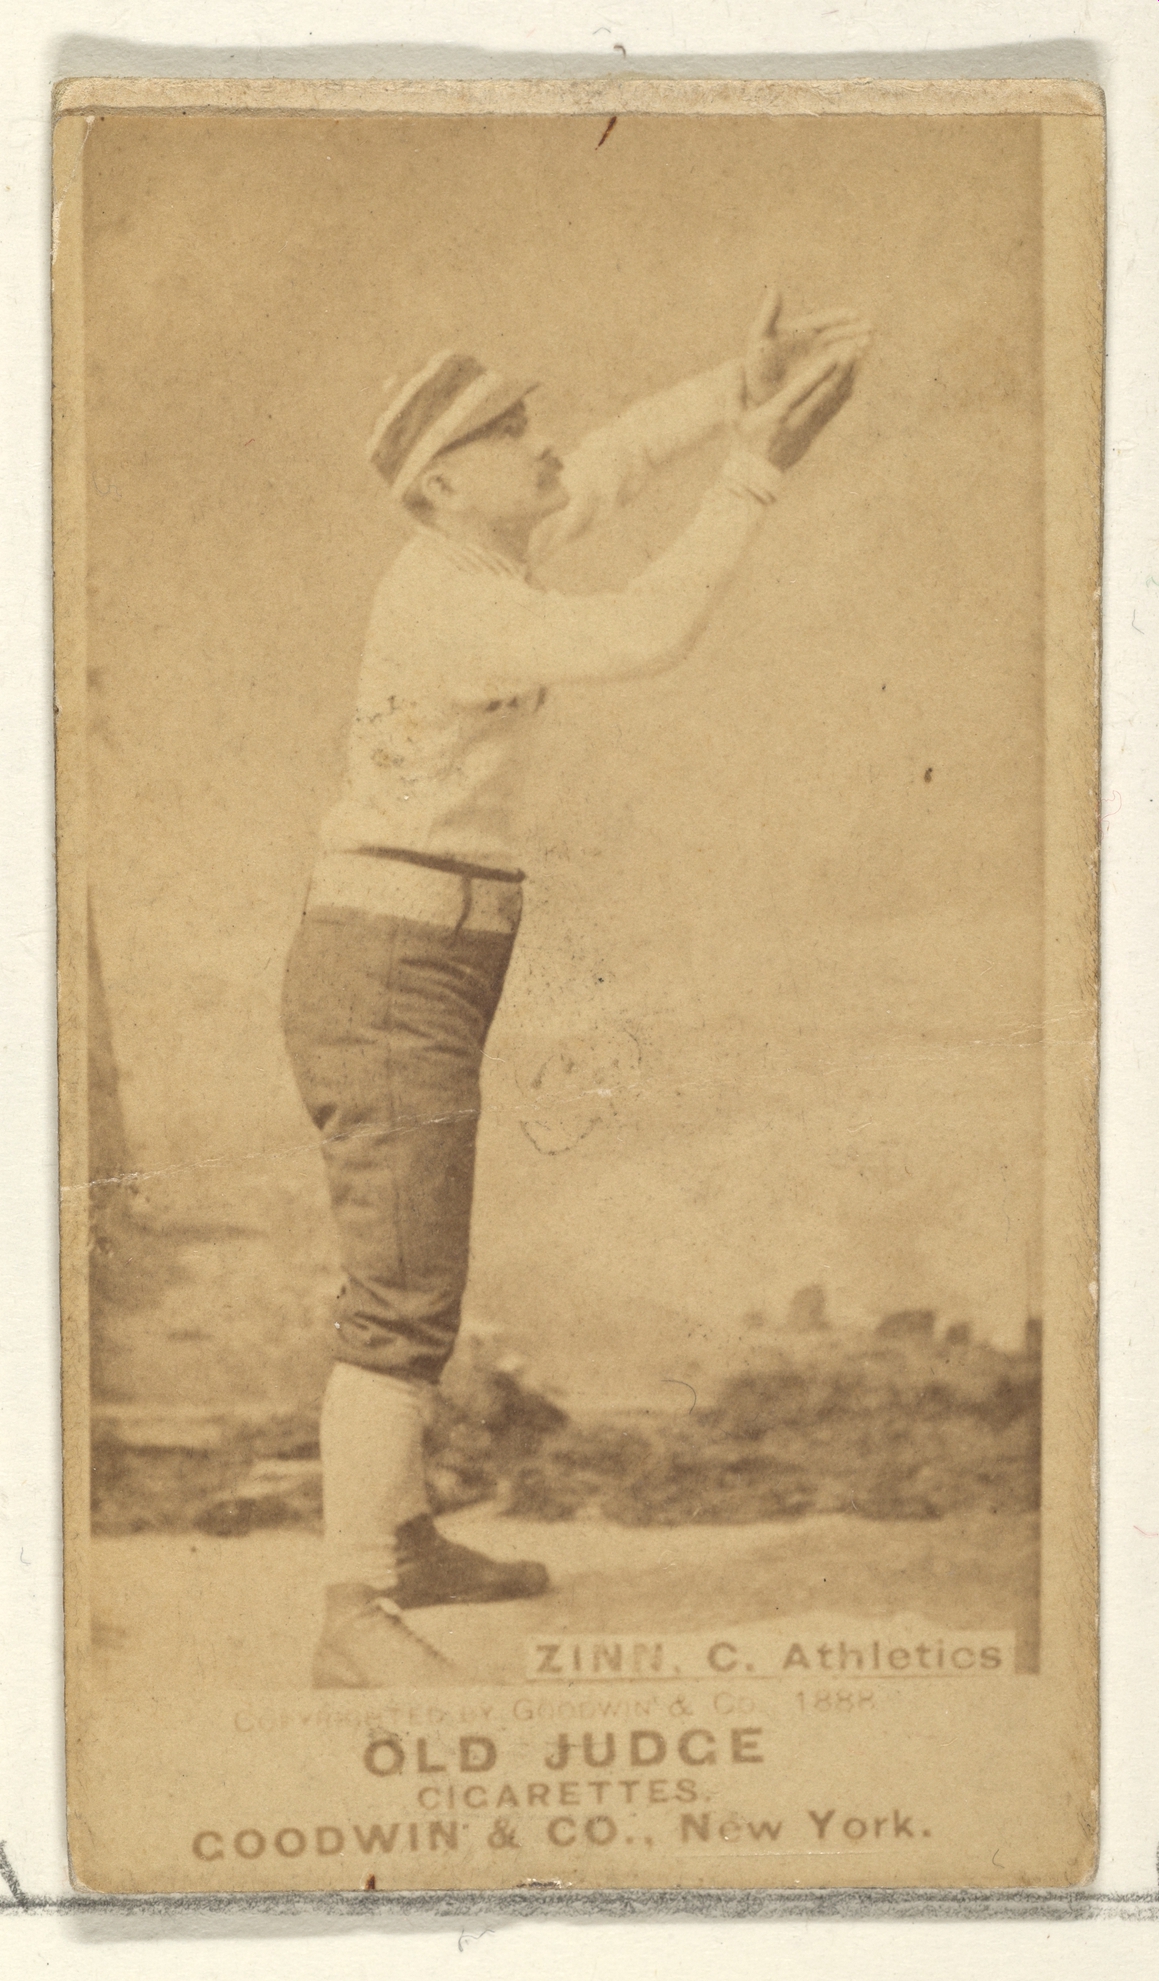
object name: baseball card, photograph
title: Zinn, Catcher, Philadelphia Athletics, from the Old Judge series (N172) for Old Judge Cigarettes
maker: goodwin & company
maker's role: publisher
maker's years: 1850-1950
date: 1888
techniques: albumen silver print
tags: men,portraits,baseball,athletes